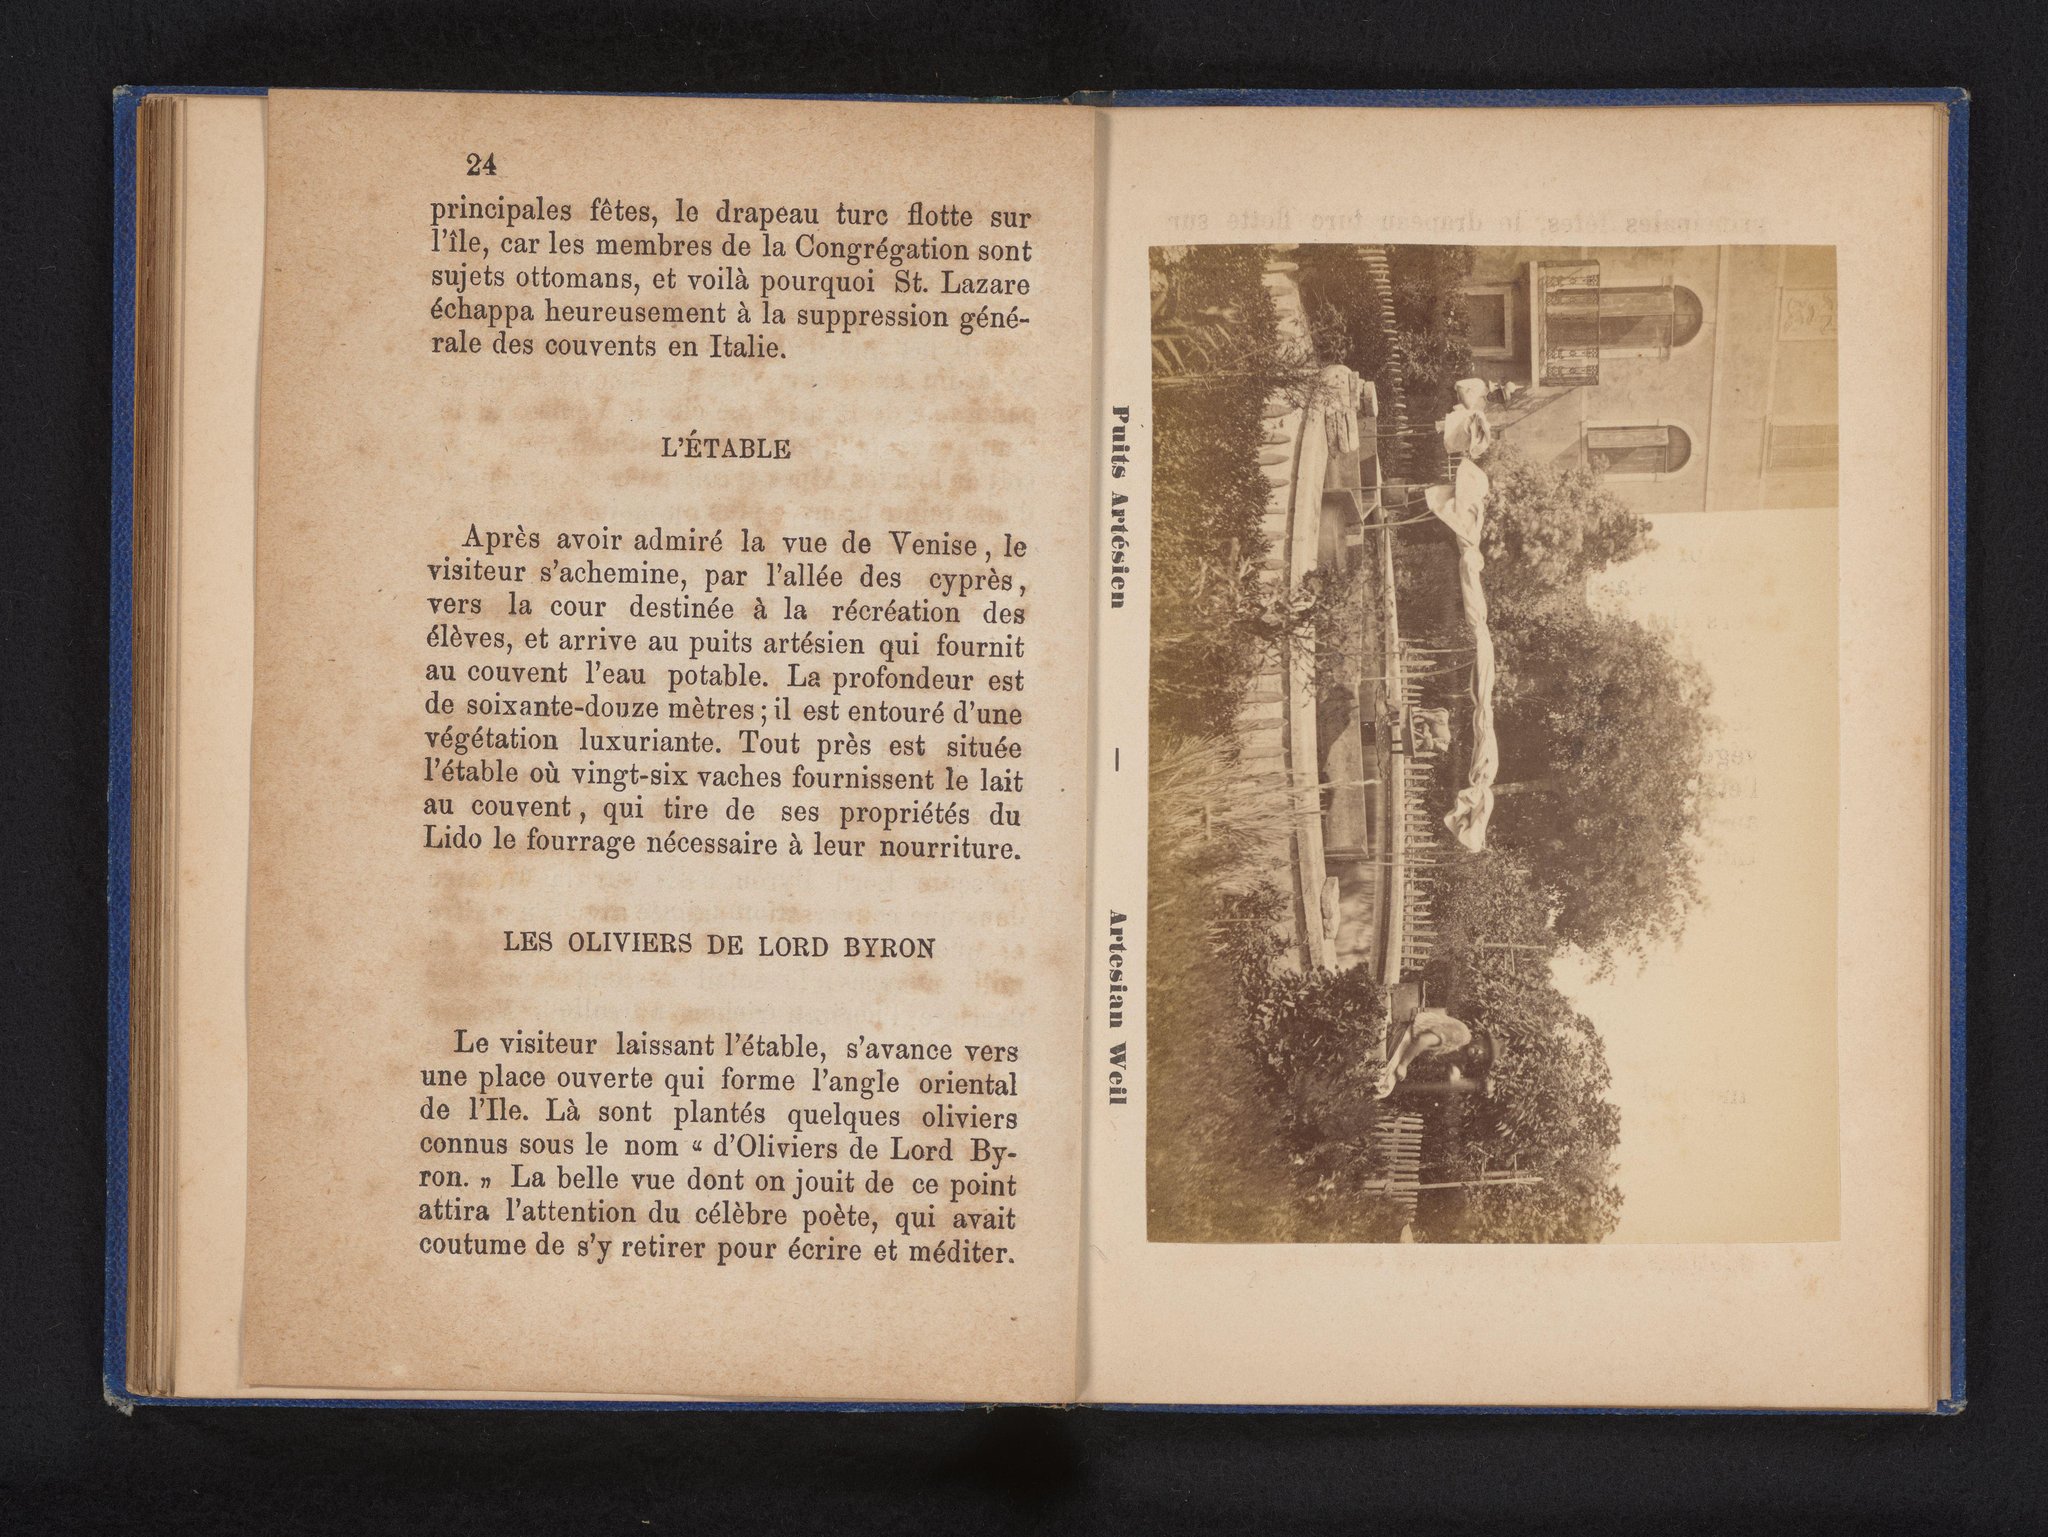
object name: page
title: Waterbron bij San Lazzaro degli Armeni, Venetië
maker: Anonymous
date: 1874-1879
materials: paper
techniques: albumen print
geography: venice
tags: well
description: Foto op ongenummerde pagina tegenover pagina 24.